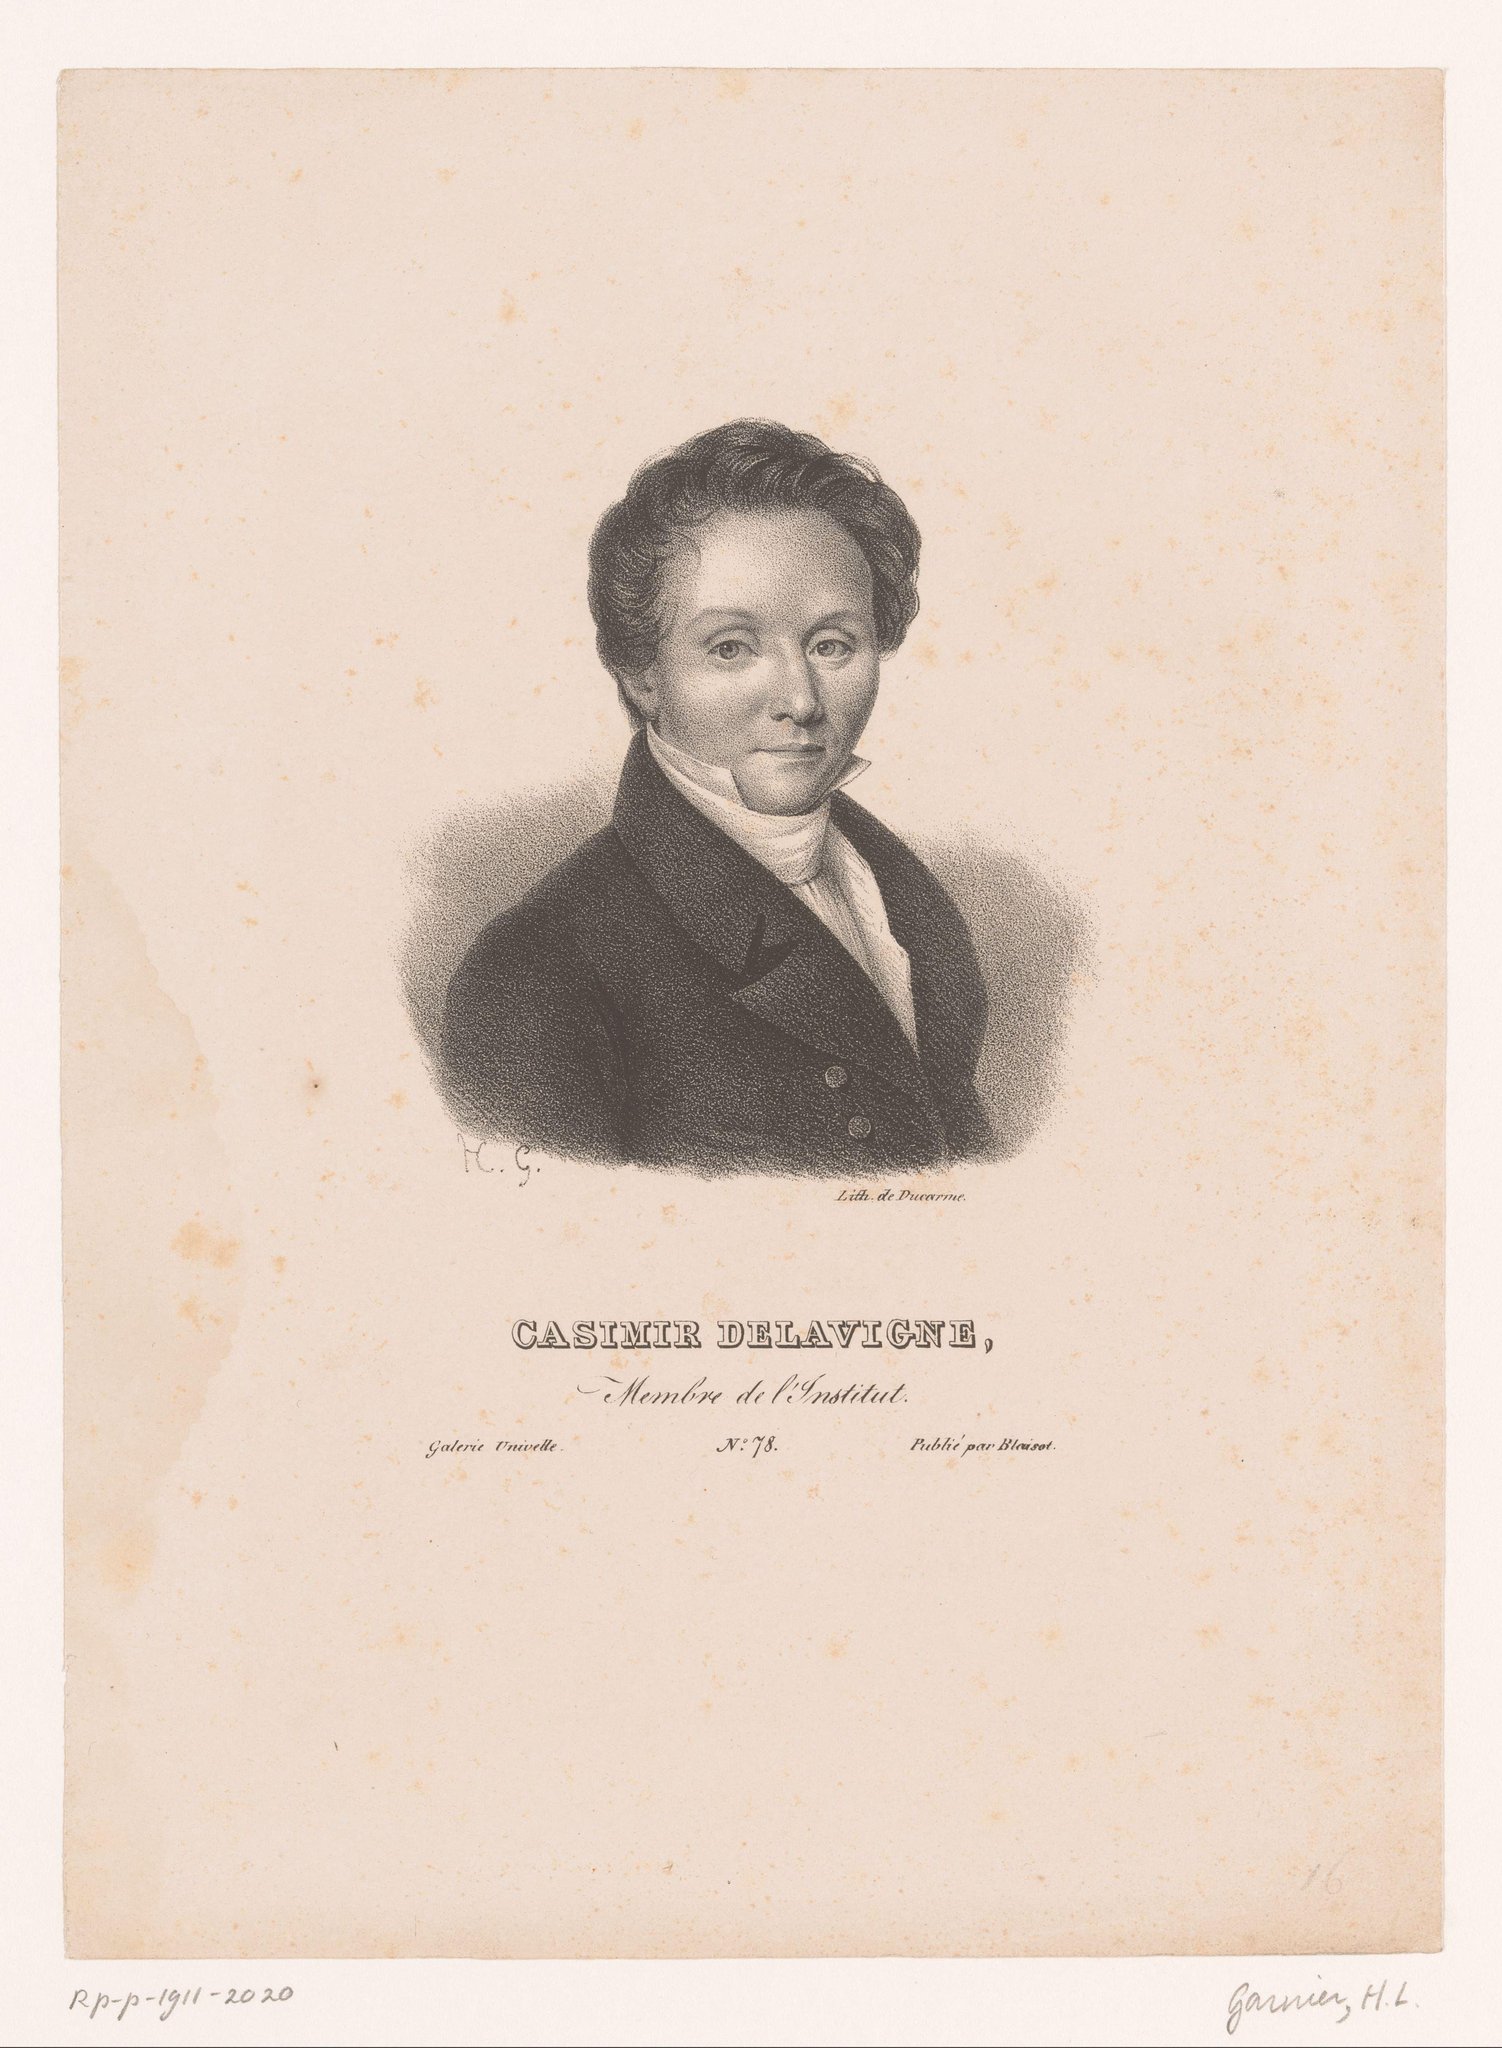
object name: print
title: Casimir Delavigne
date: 1823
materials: paper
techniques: lithograph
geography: paris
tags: historical persons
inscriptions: collector's mark: Lugt 2228a